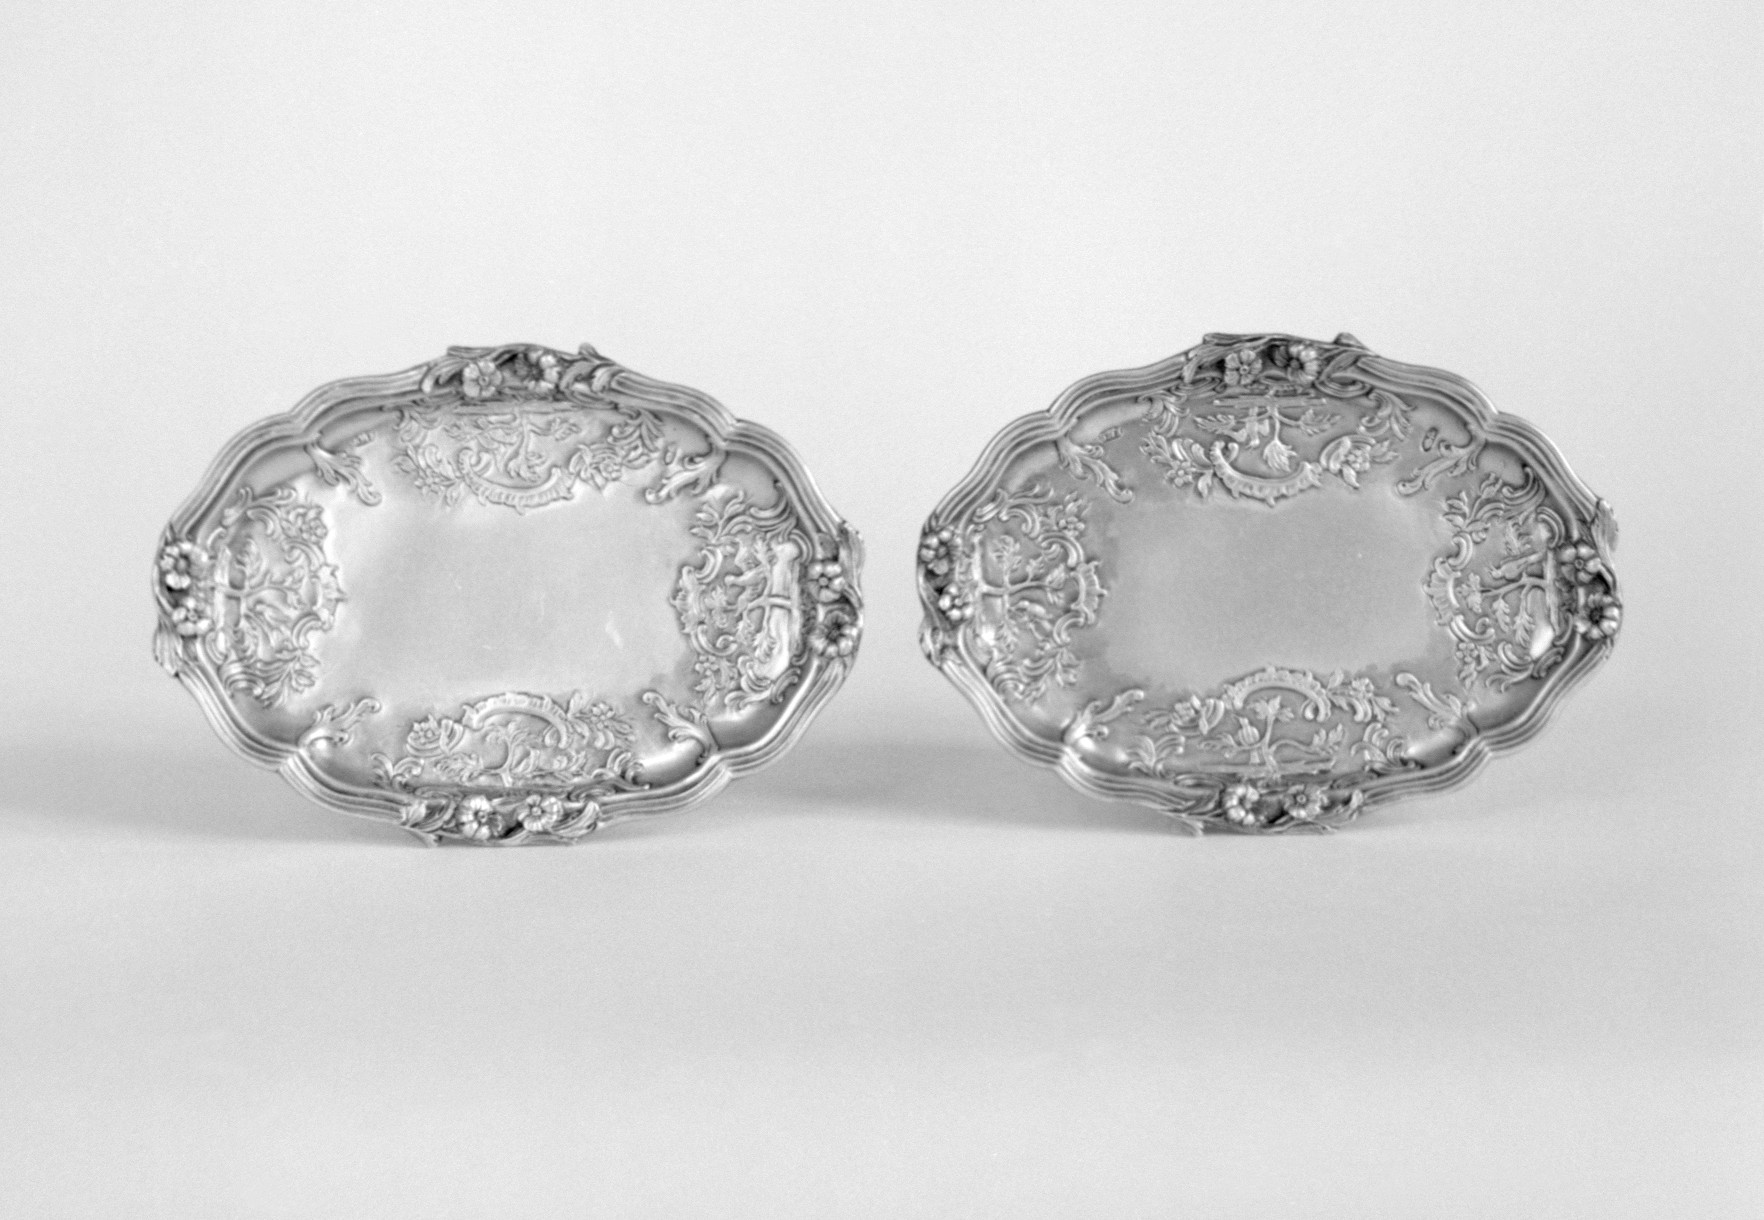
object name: tray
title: Small tray (one of a pair)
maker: johann martin satzger i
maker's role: maker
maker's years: 1707-1785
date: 1761-1763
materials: silver gilt